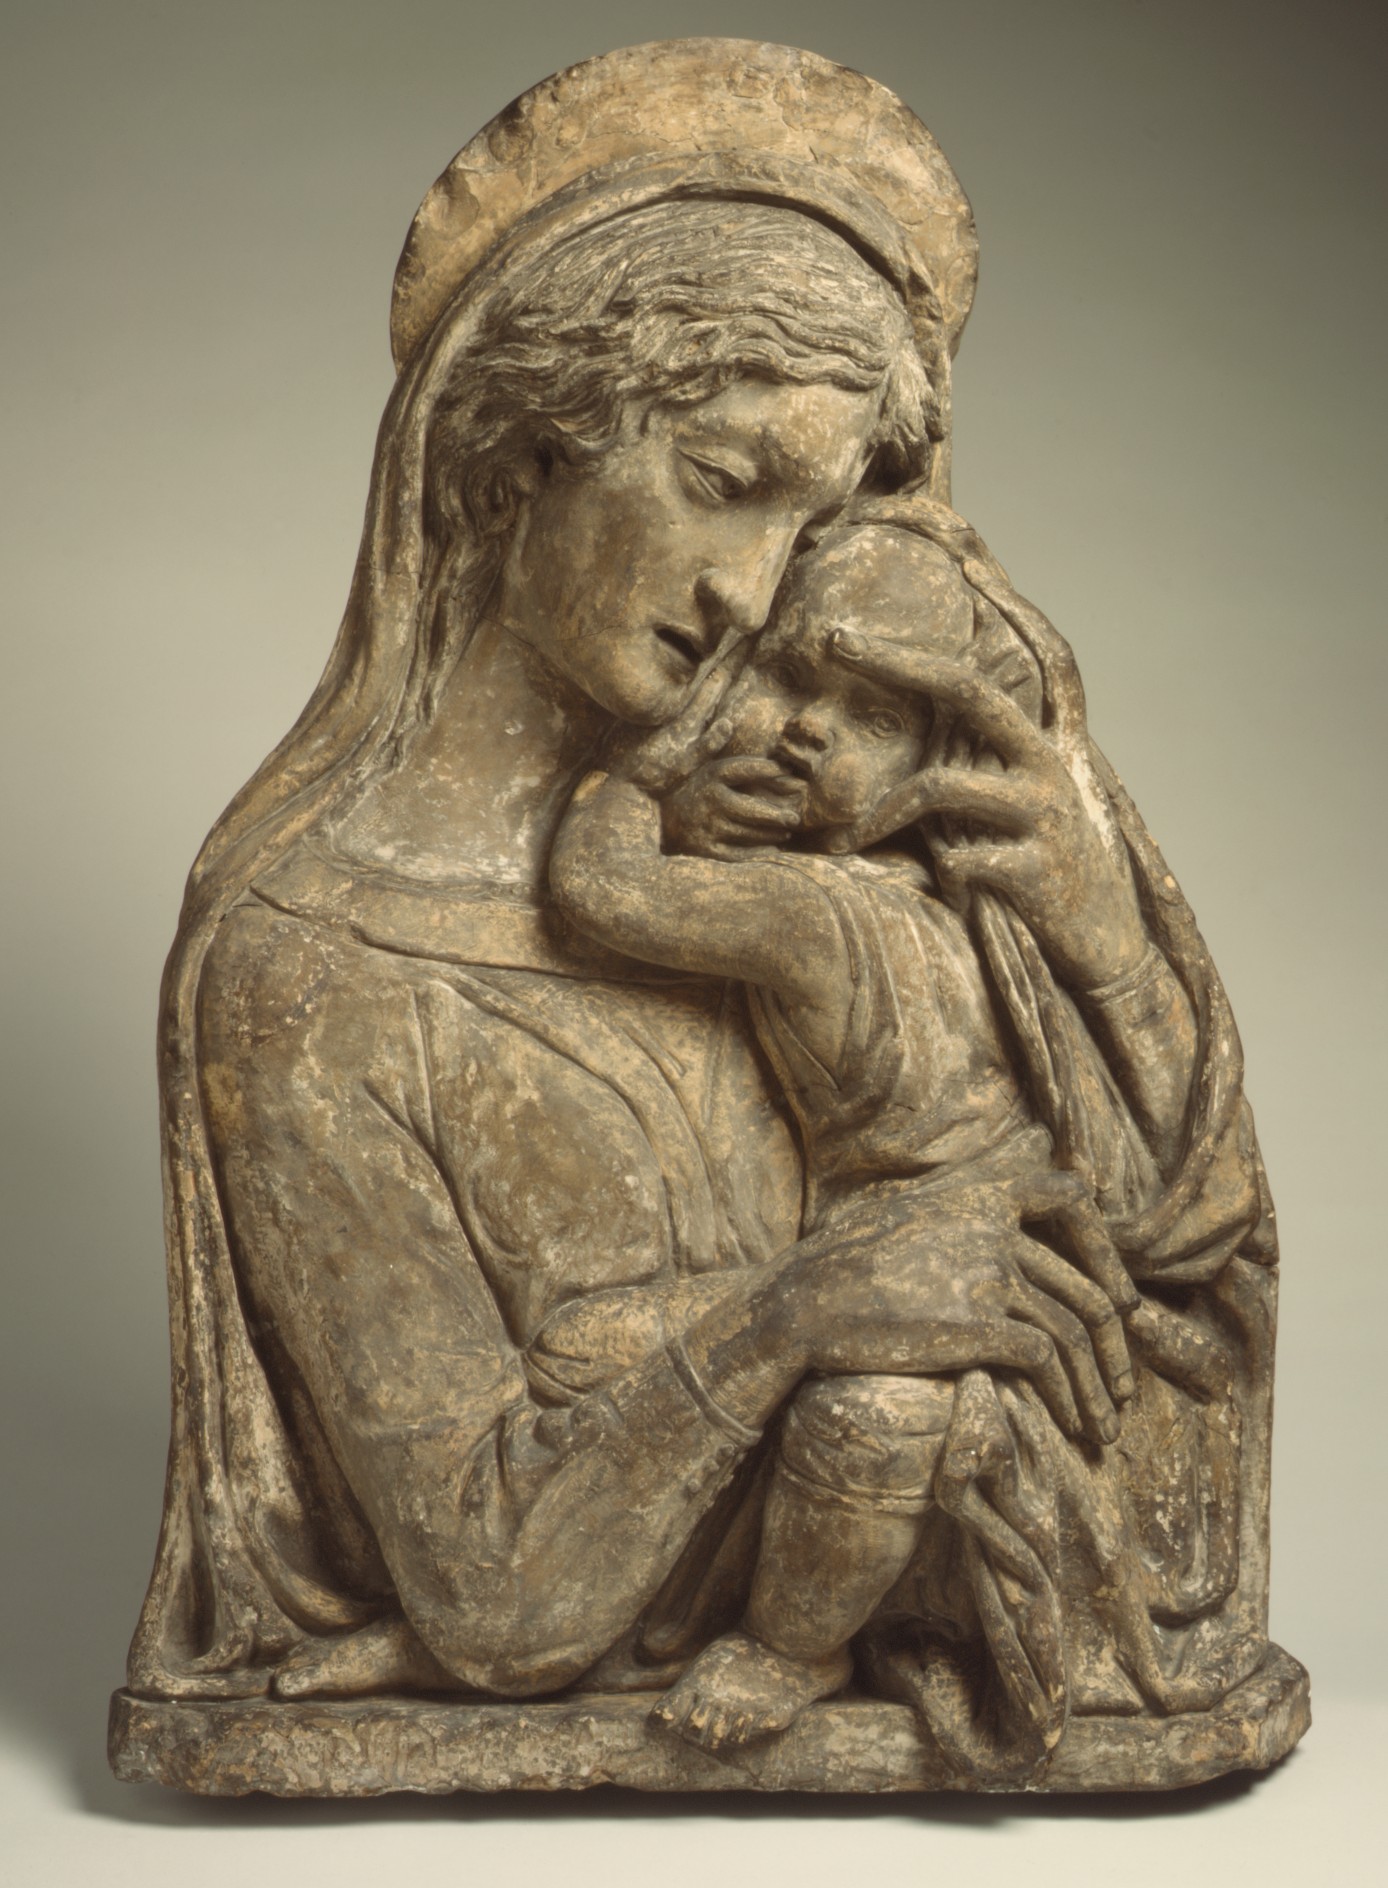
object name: relief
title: Madonna and Child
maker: donatello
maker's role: artist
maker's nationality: italian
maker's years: 1386-1466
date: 1401-1500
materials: terracotta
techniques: polychrome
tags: madonna and child